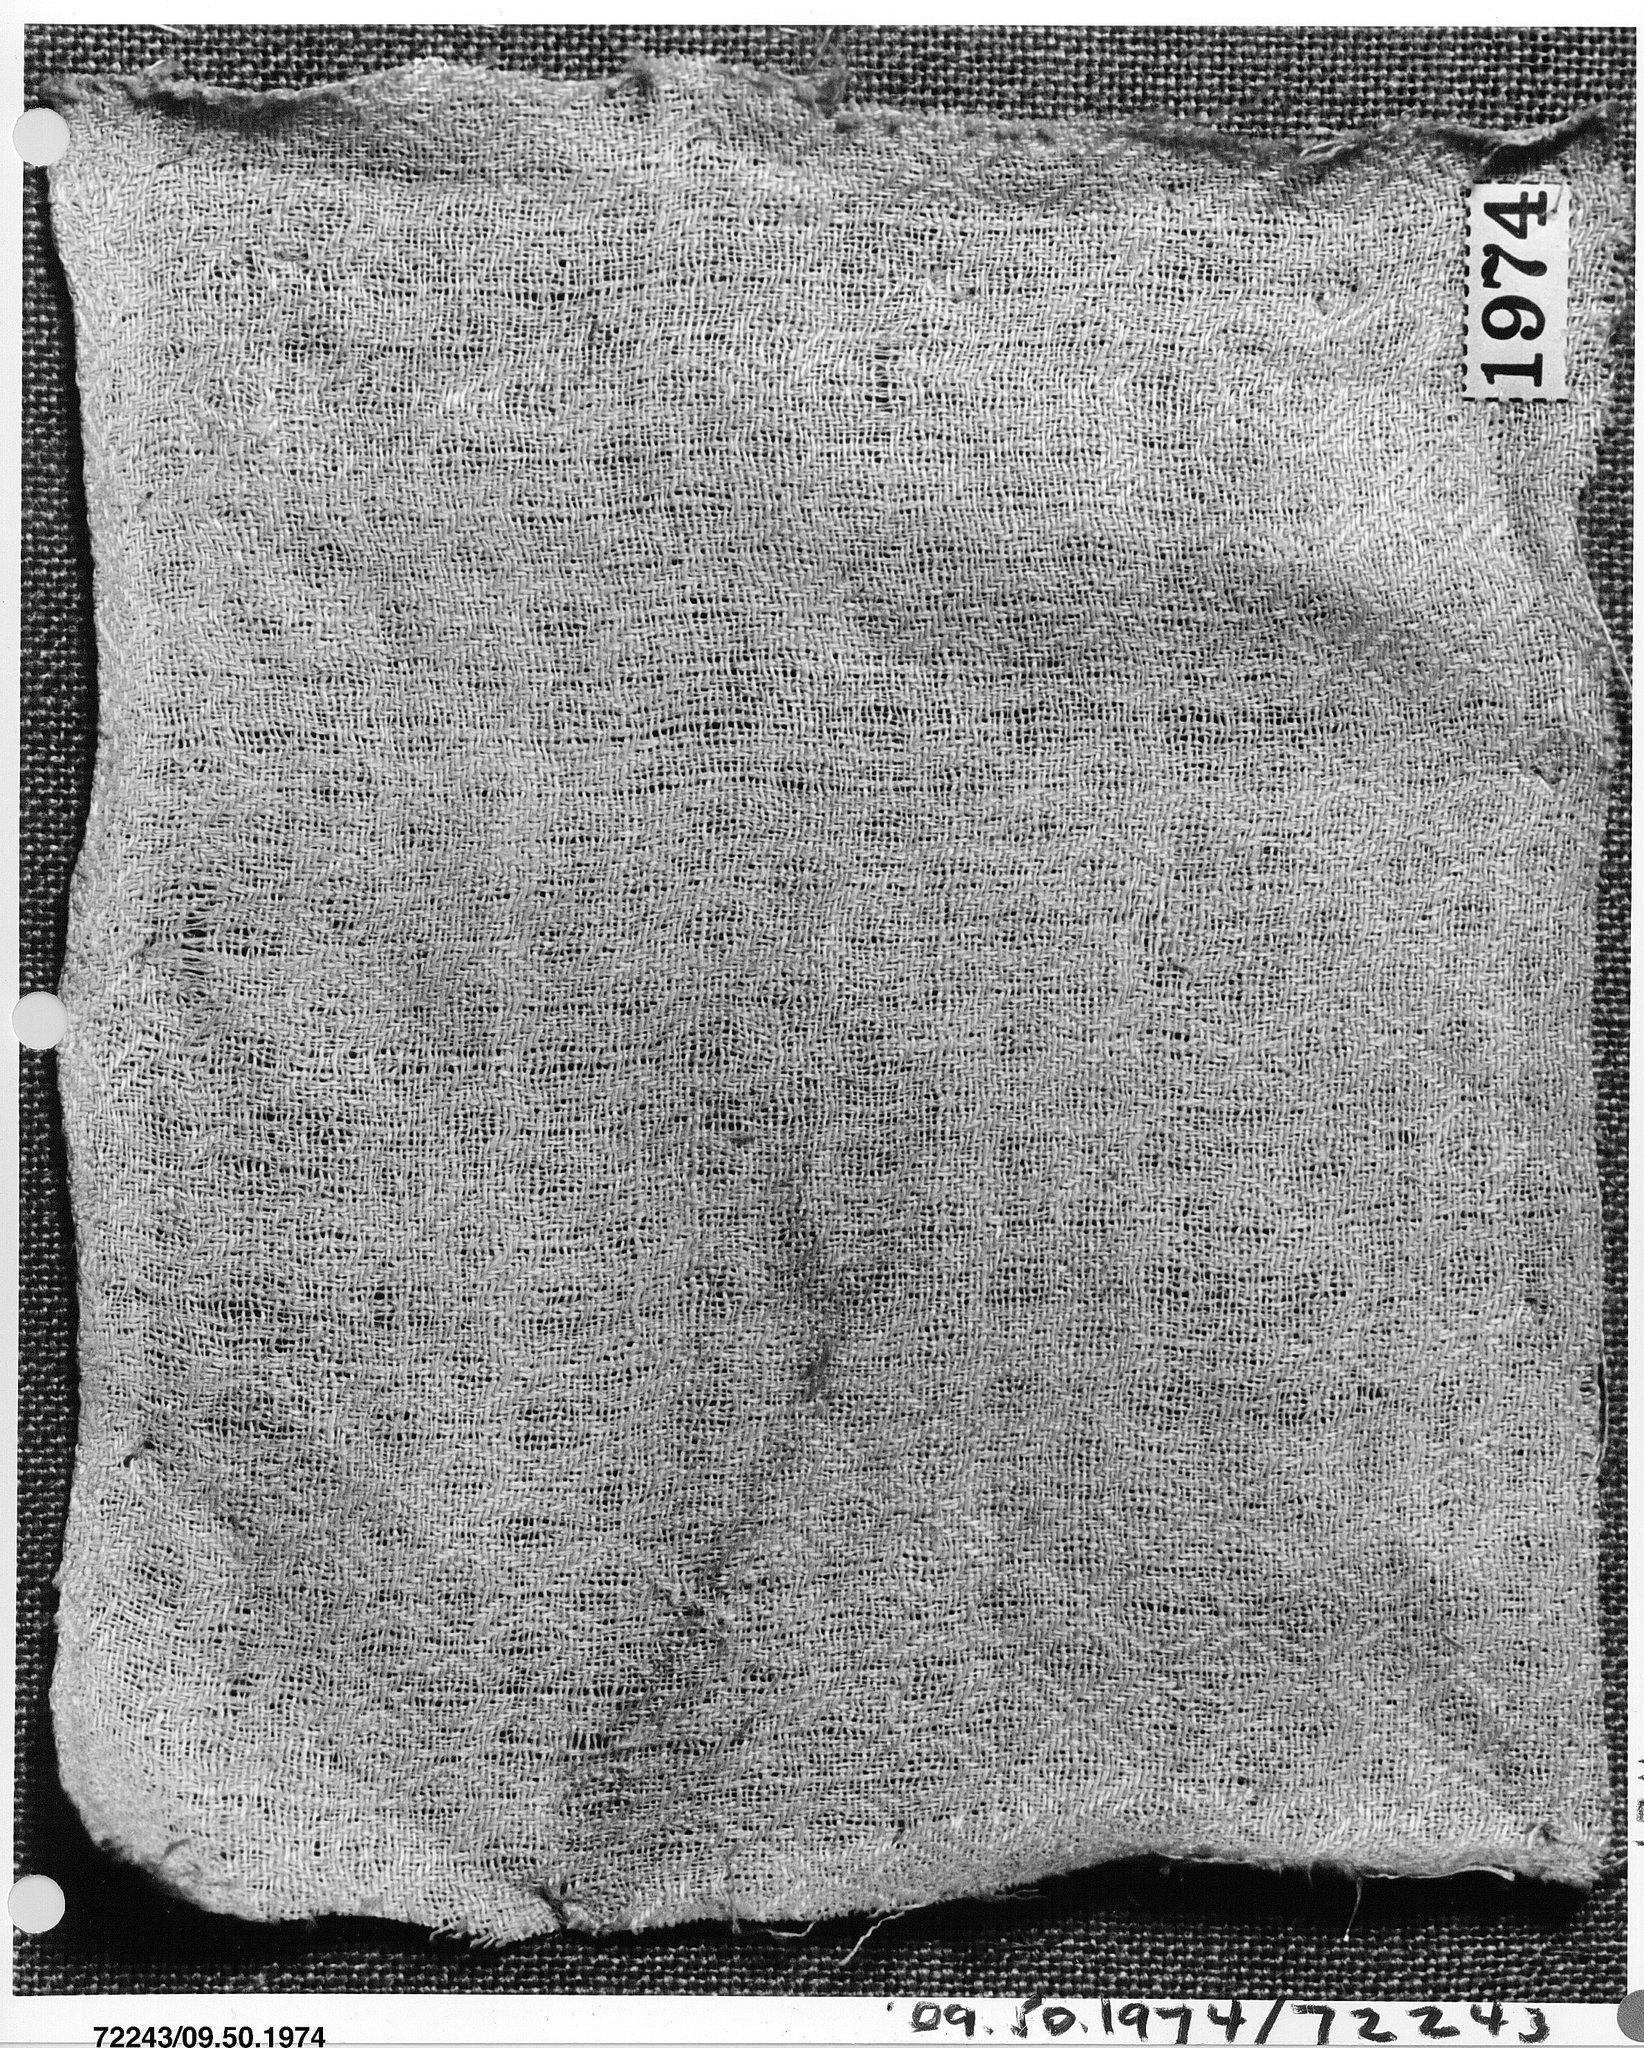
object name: piece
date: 1701-1900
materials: linen